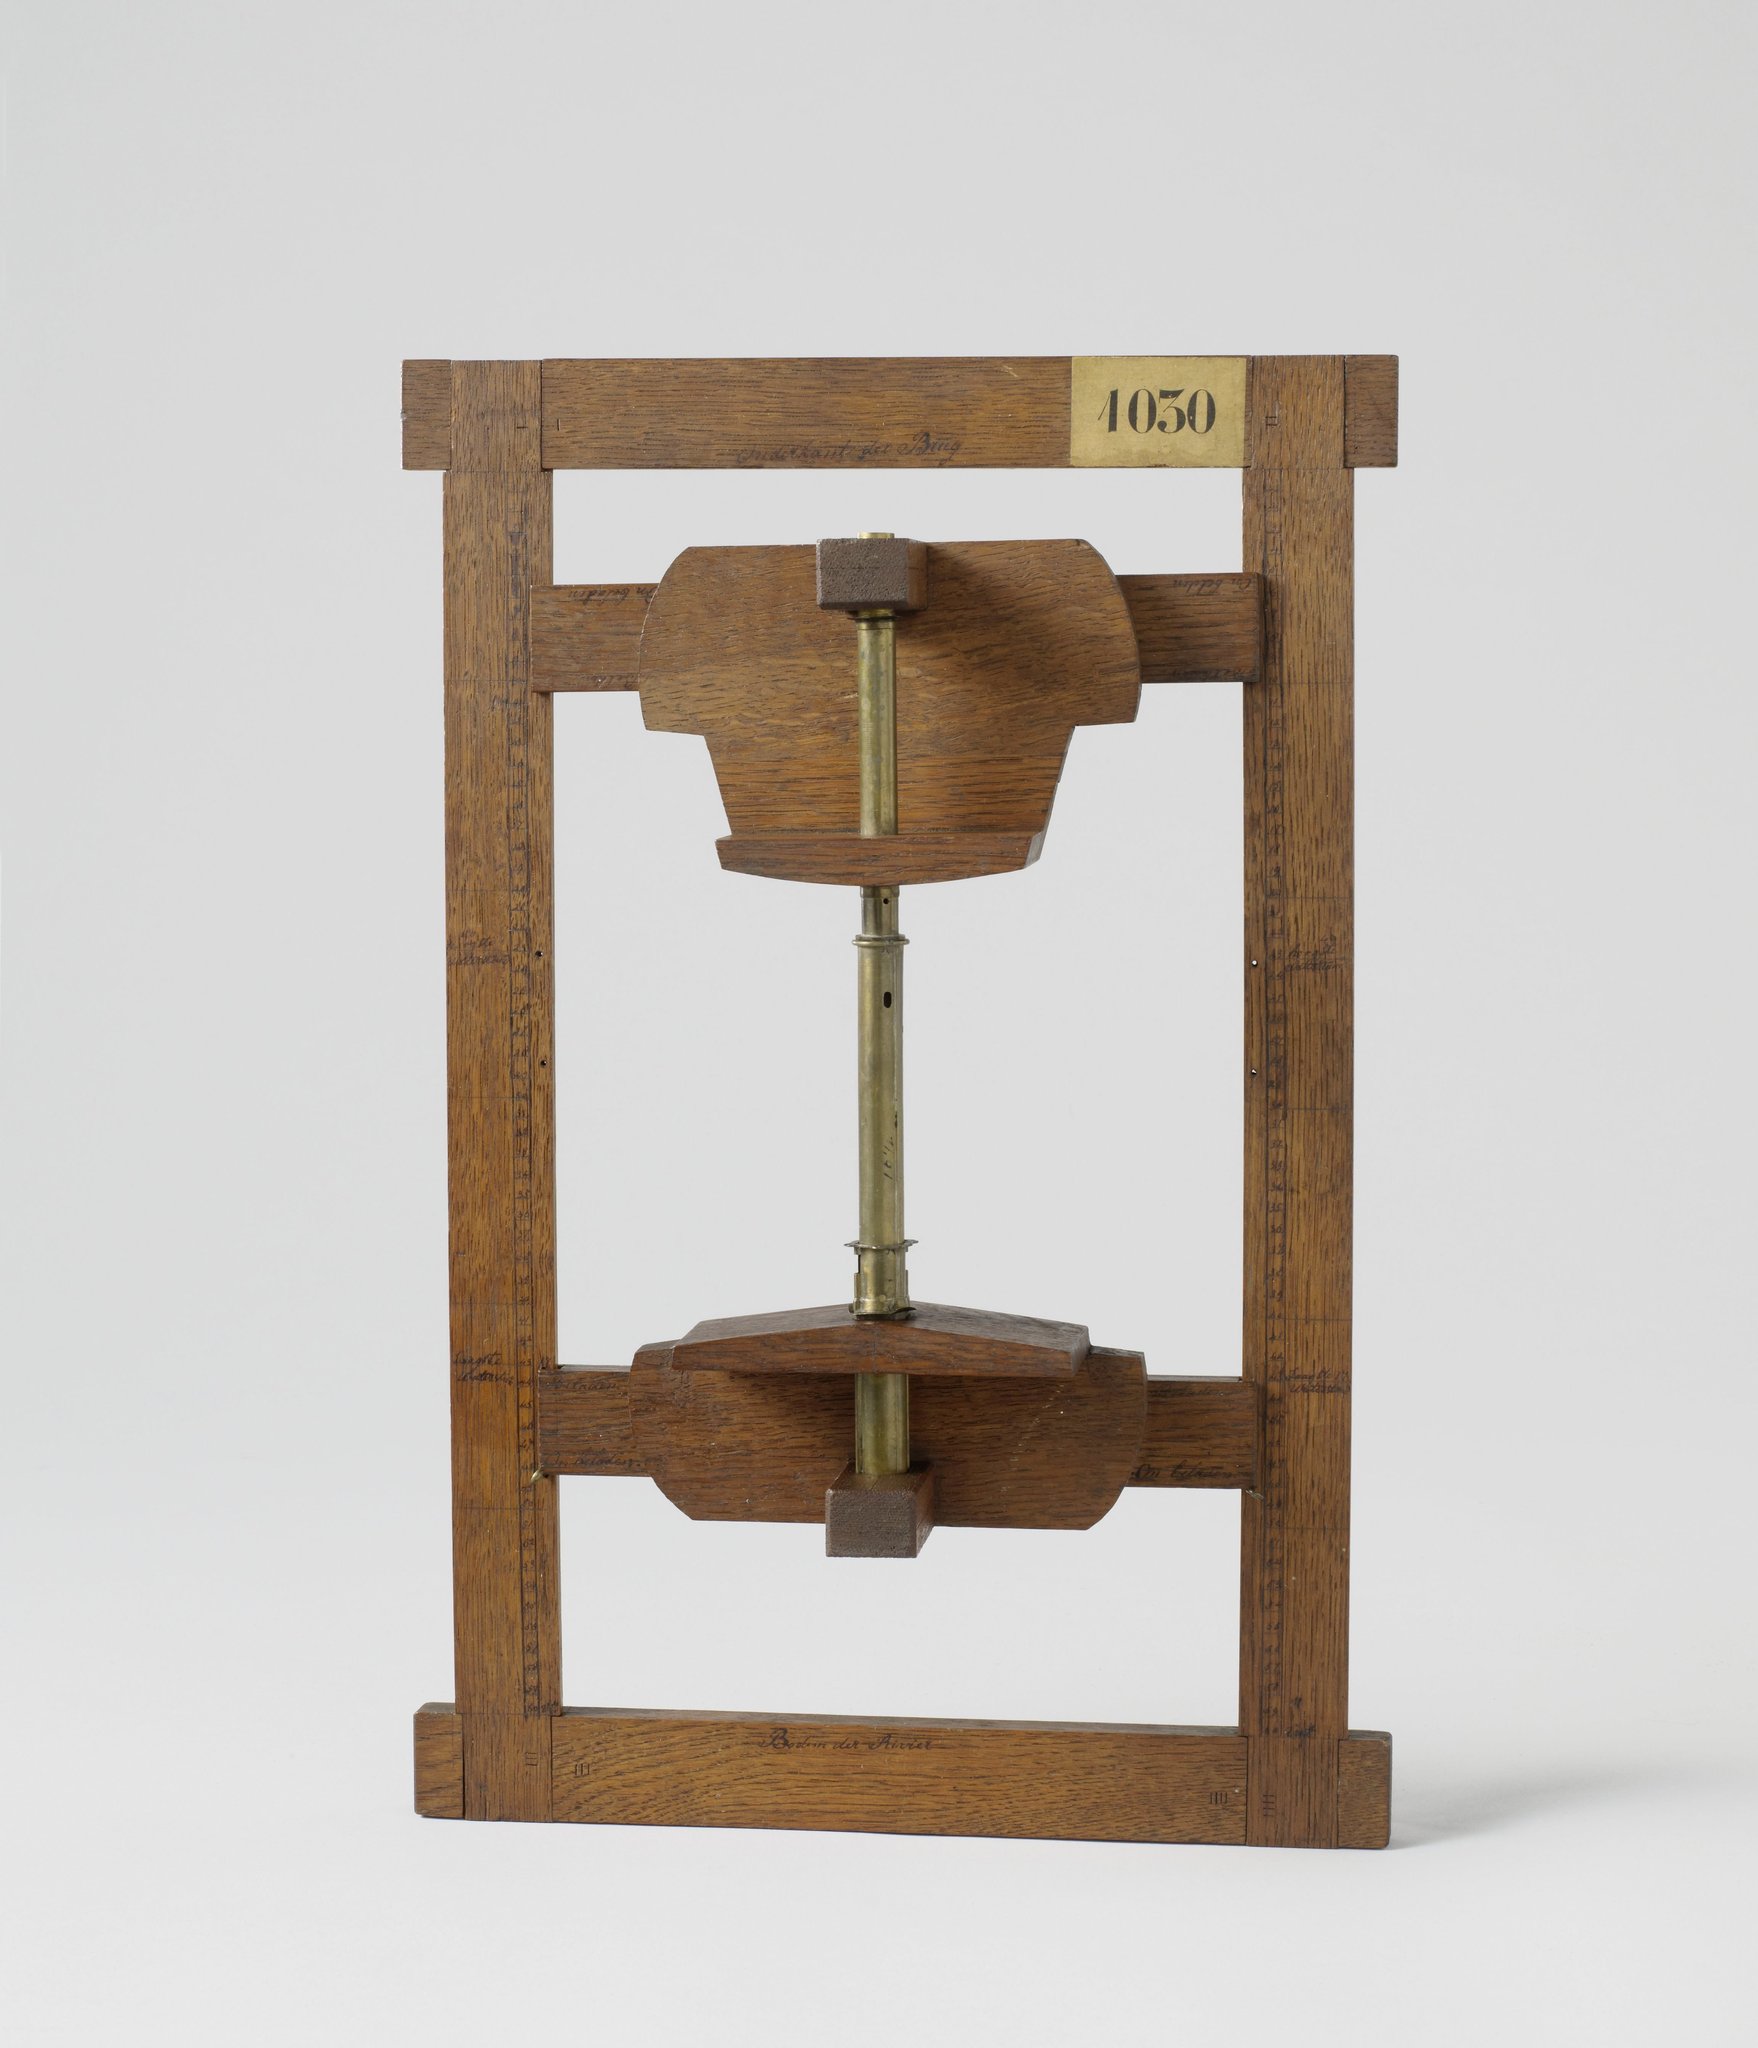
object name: demonstration model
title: Model Indicating the Headroom of the Rhine Bridge at Cologne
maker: petrus van der loo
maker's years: 1806-1864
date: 1860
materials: brass, wood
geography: the hague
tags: cologne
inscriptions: label, top right: ‘1030’ former inventory label, inscription, bottom centre: ‘Bodem der Rivier hoogste’, inscription, top centre: ‘Onderkant der Brug’, inscription, left and right, twice: ‘Waterstand / Laagste / Waterstand’, inscription, on the cross sections, four times: ‘Beladen / Onbeladen’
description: Schetsmodel van de doorvaarhoogte van een brug, bestaande uit een houten frame dat de hoogte tussen de onderkant van de brug en de bodem der rivier aangeeft; hoogtemarkeringen in (Rijnlandse) voeten aan beide zijkanten en hoog- en laagwater aanduiding. Twee doorsnedes van een schip met een schoorsteen kunnen in het frame op verschillende hoogtes gehangen worden. Een van deze modellen heeft een uitschuifbare schoorsteen. Schaal 1:50 (afgeleid).